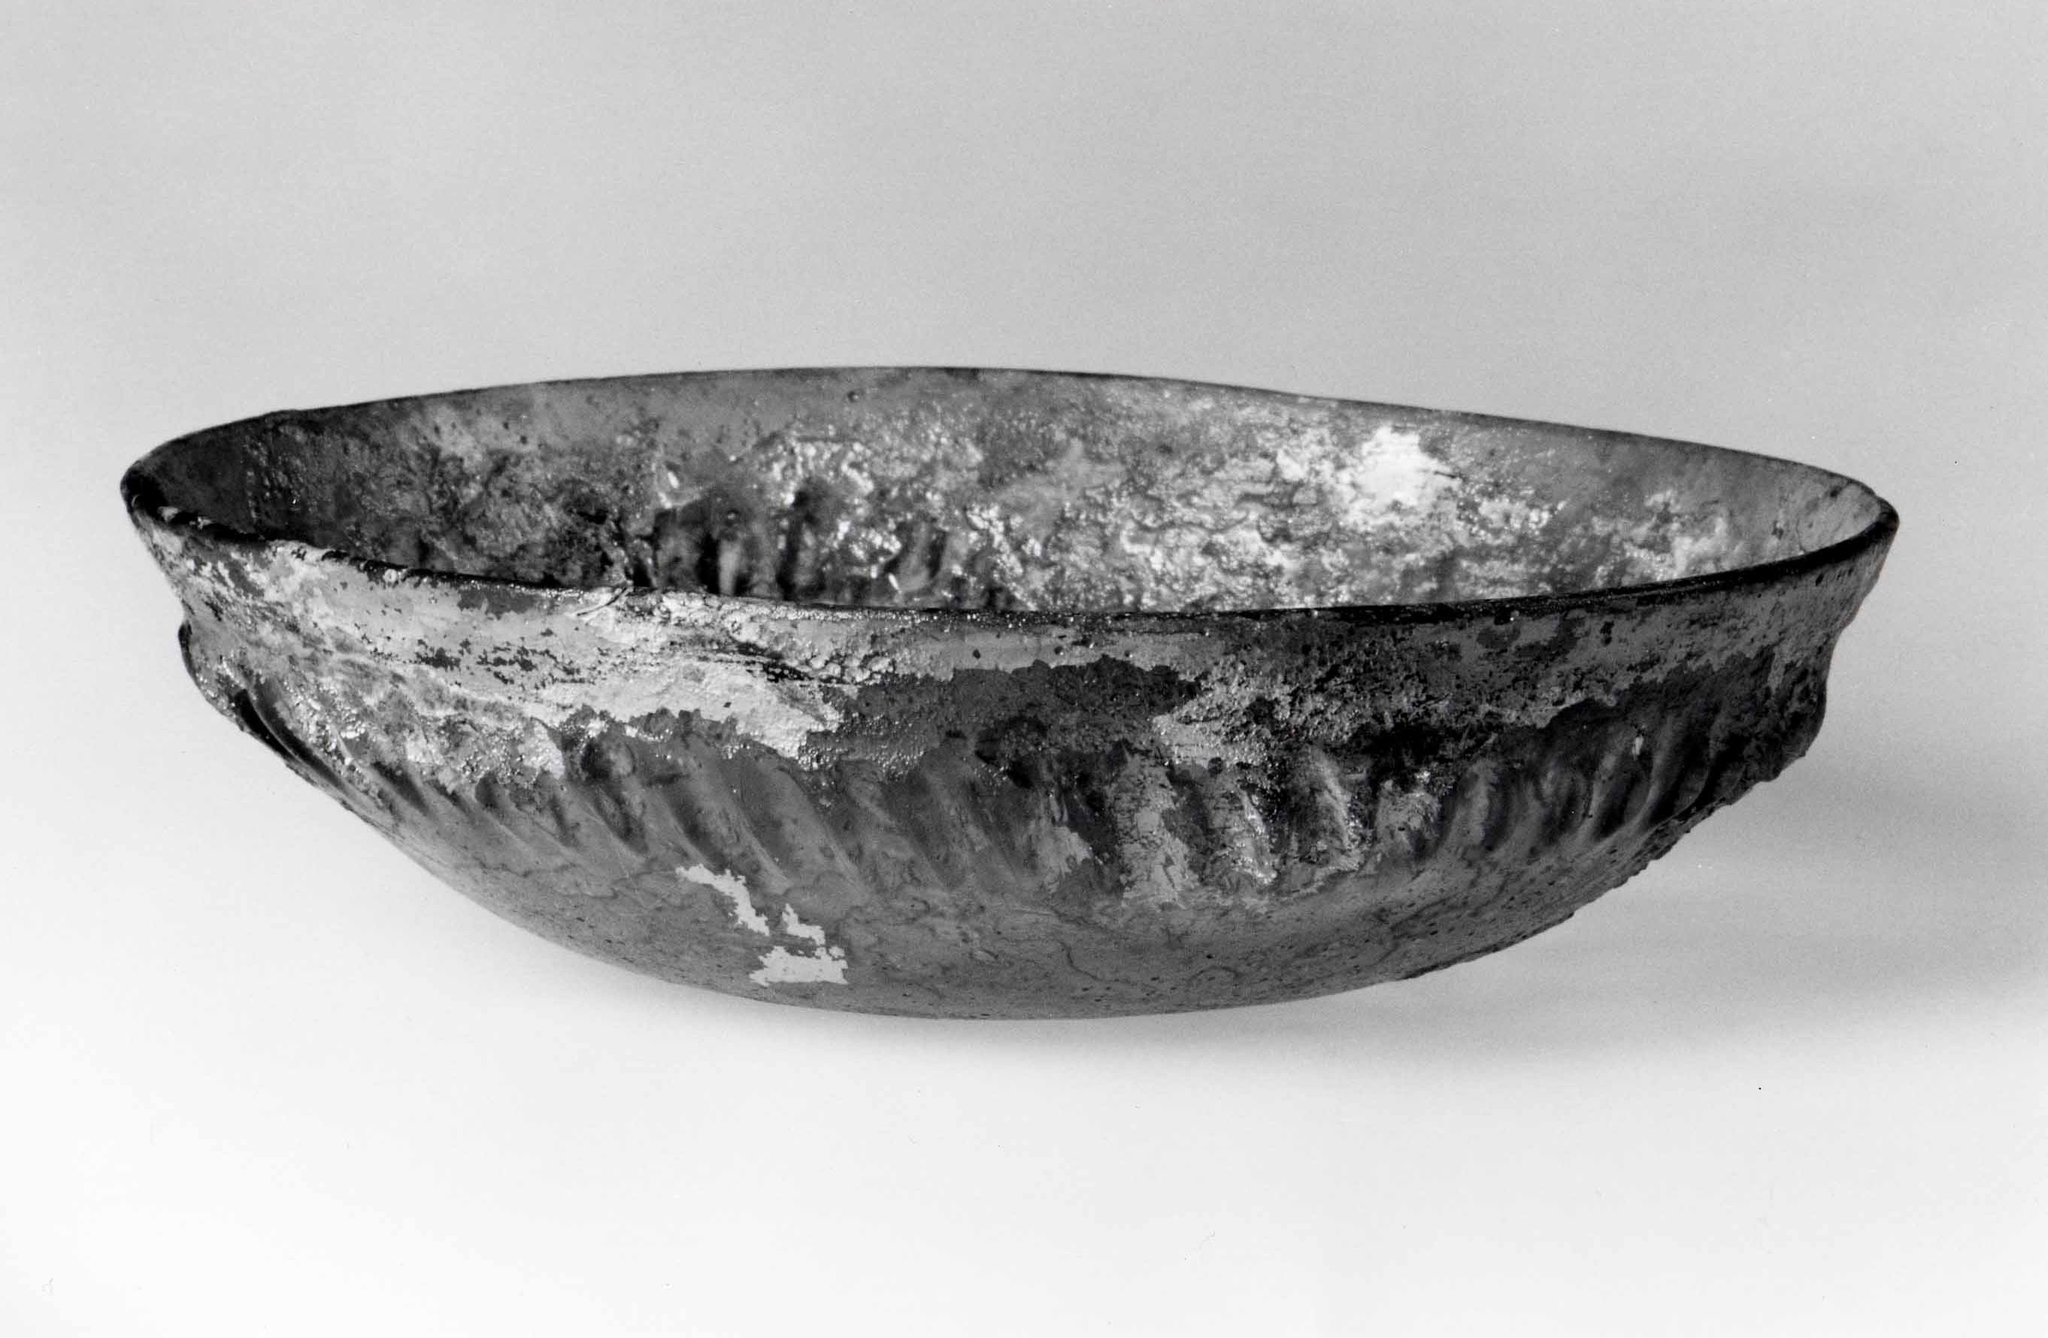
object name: bowl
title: Ribbed bowl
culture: roman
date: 1-100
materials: glass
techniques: casting, cutting, polish, stamping